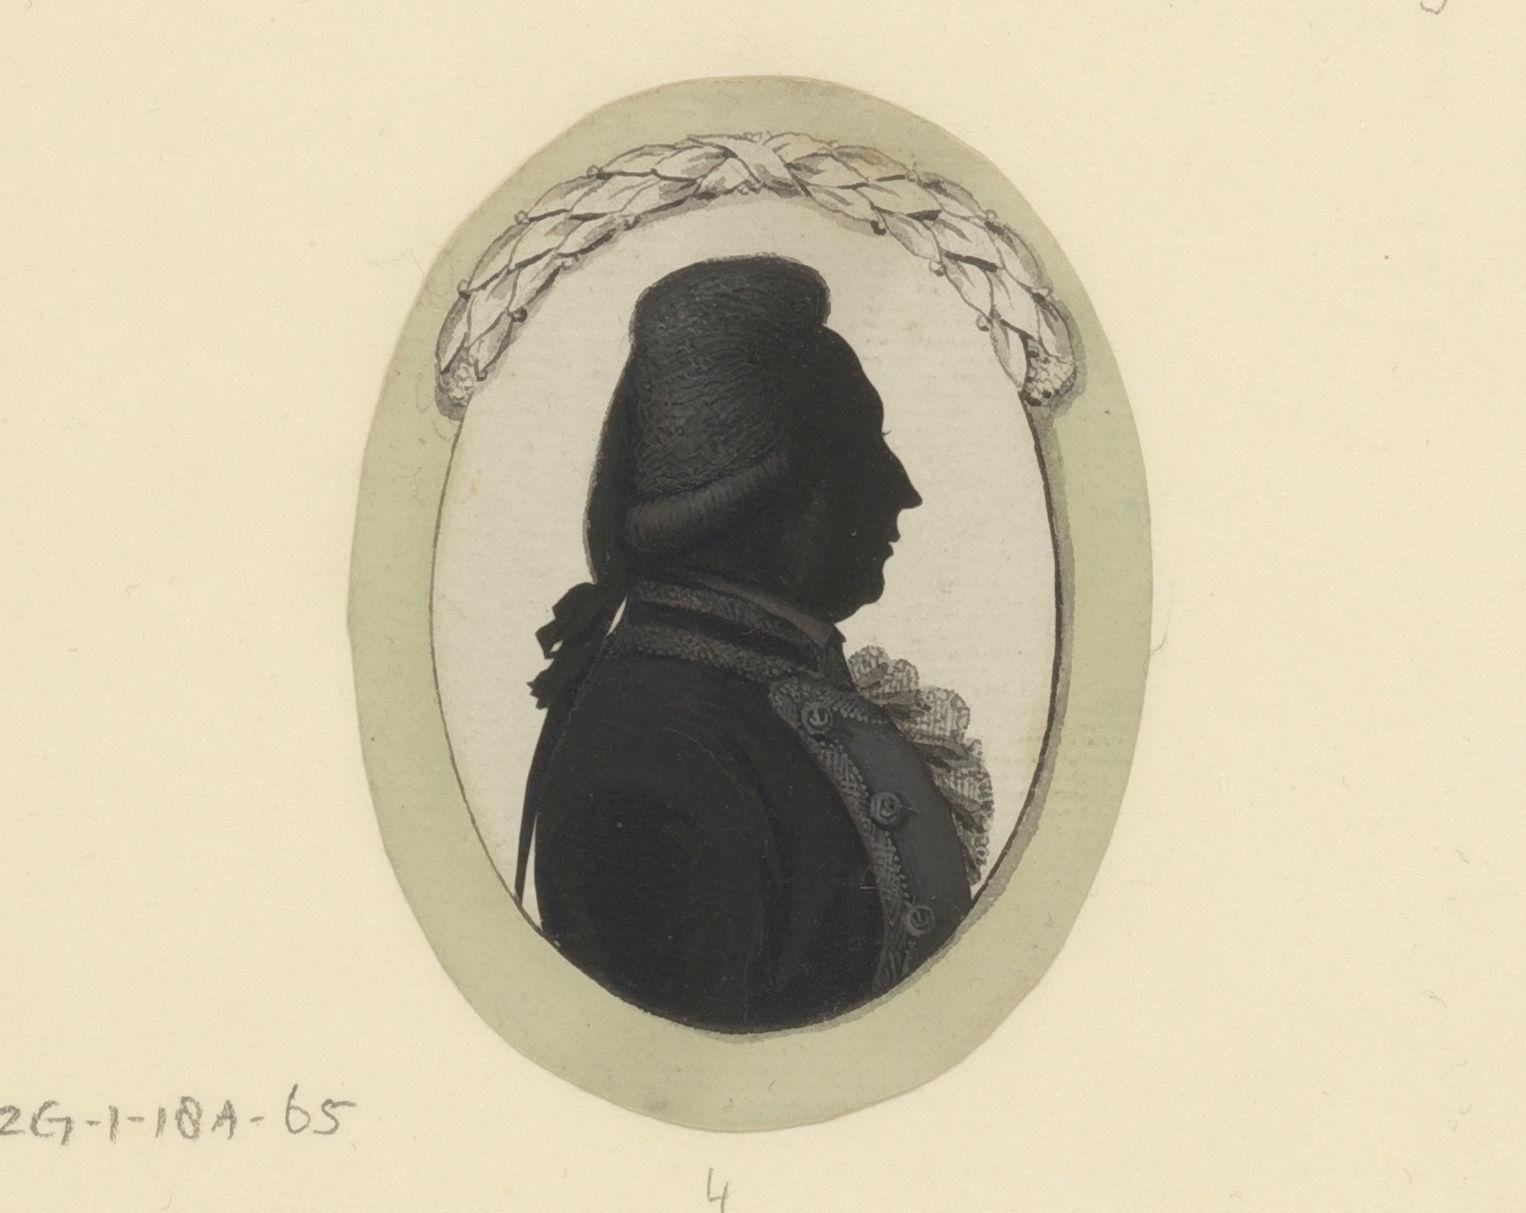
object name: cut paper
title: Silhouetportret van een onbekende man, mogelijk K.P. Stambke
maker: joseph adolf schmetterling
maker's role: draughtsman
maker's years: 1751-1828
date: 1775-1799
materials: ink, paint, paper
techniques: brush, pen, snipping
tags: historical persons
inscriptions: collector's mark: Lugt 1641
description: Silhouetportret van een onbekende man, mogelijk K.P. Stambke. Borststuk van een heer en profil in uniform met een kanten jabot. Hij draagt een pruik met strik en dunne staart. Portret naar rechts. Onderwerpsrubrieken binnen de Atlas Zeden en Gewoonten: Schoone kunsten, Silhouetportretten.